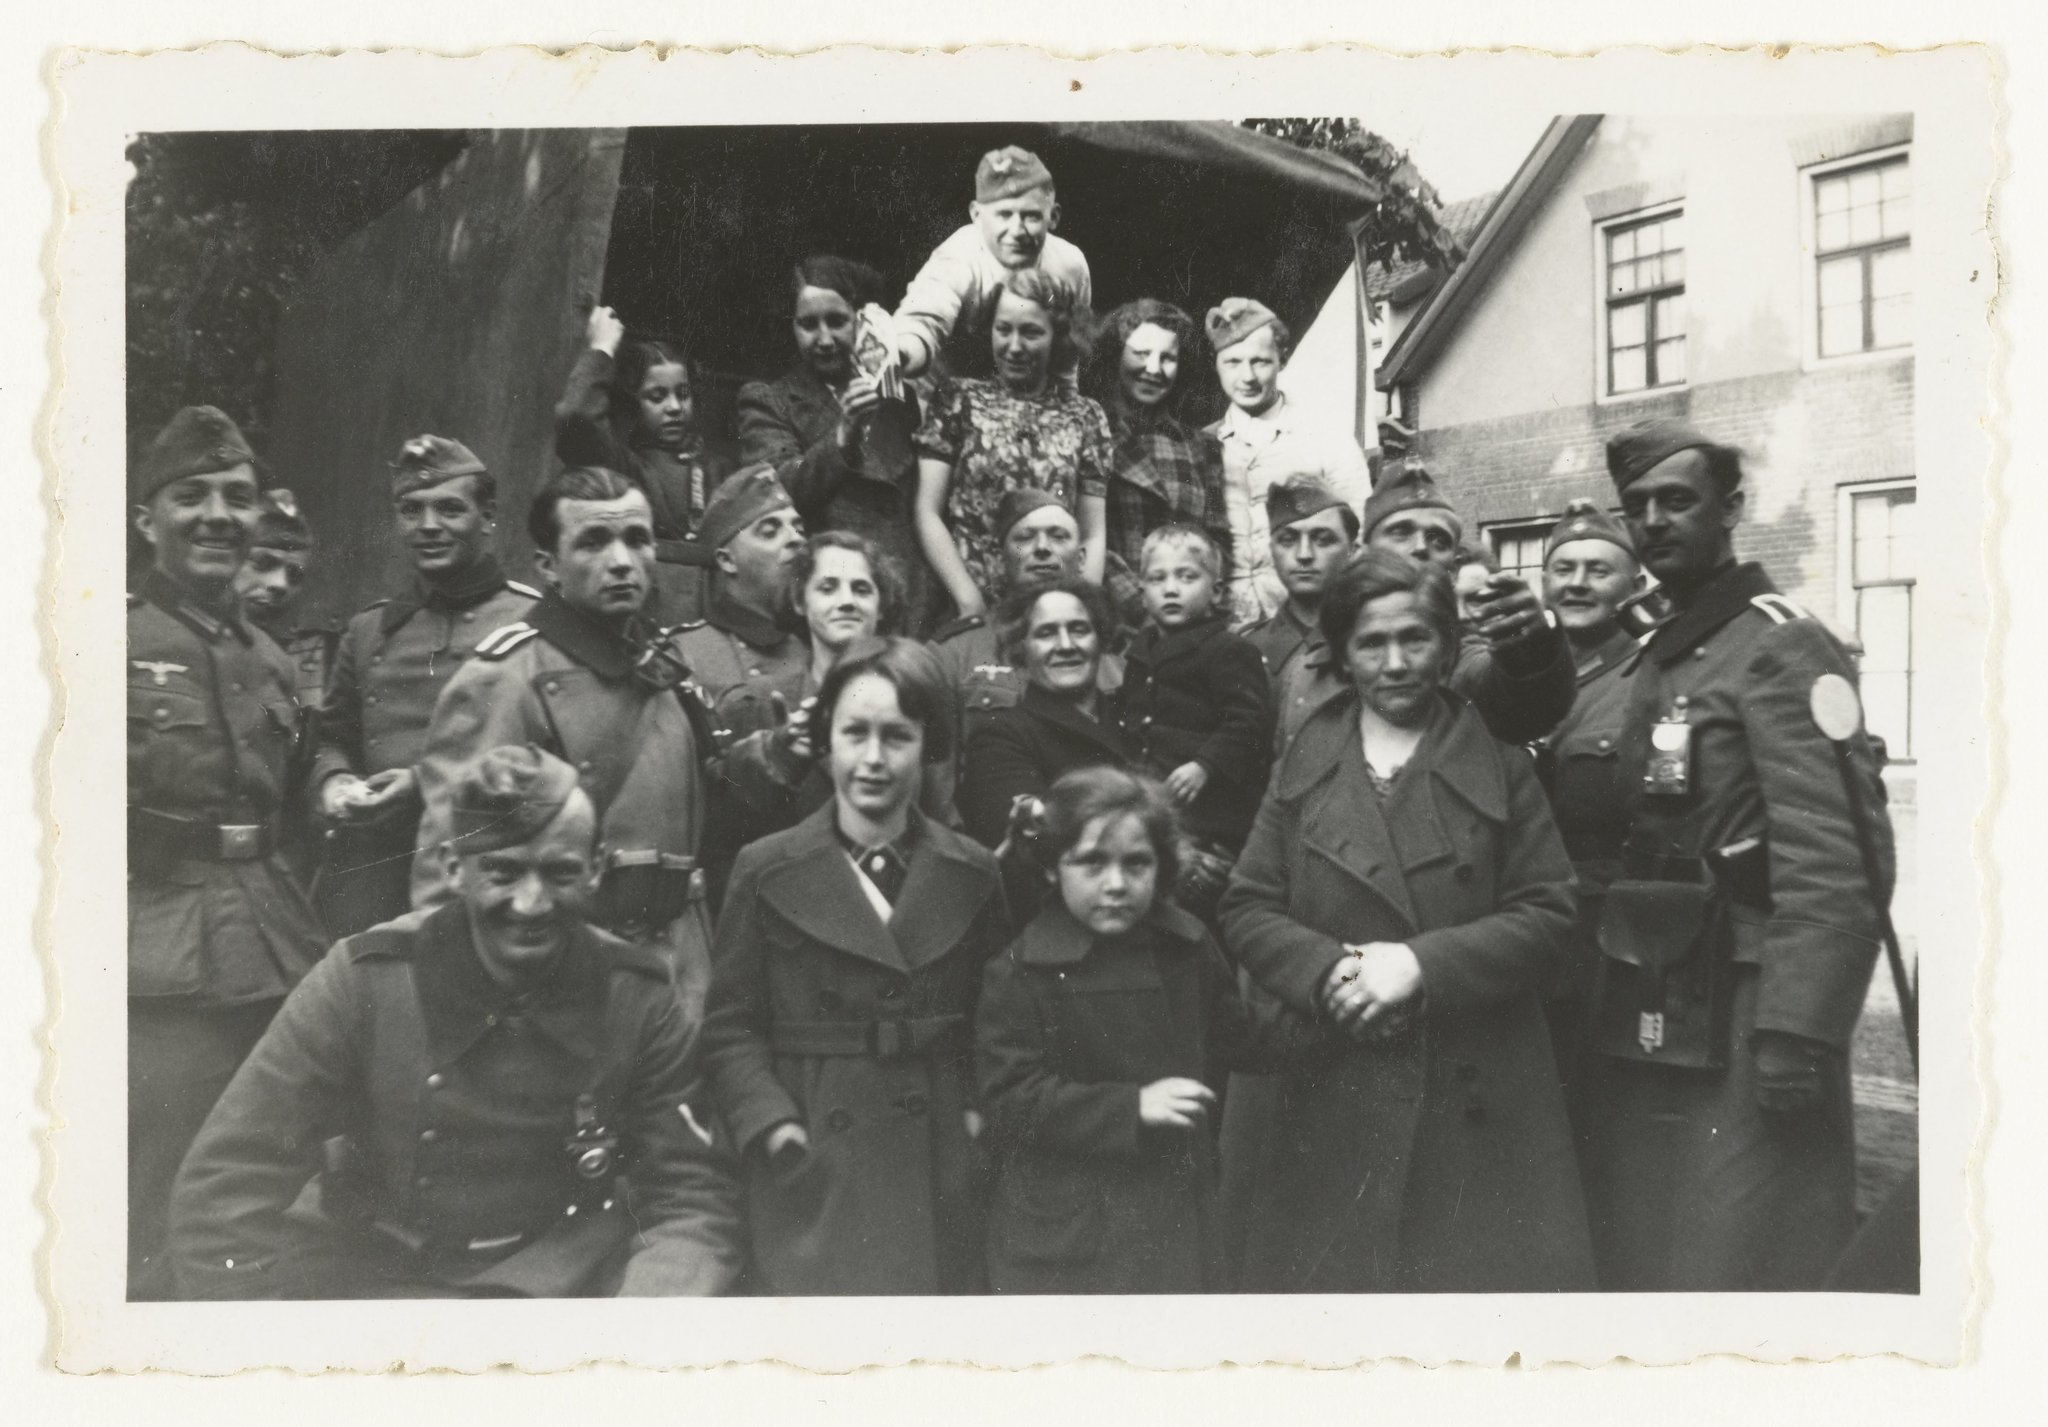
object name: photograph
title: Wehrmachtsoldaten met Nederlanders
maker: Anonymous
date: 1941-1942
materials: photographic support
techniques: gelatin silver print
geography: netherlands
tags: occupier and civilians, occupation ~ war, netherlands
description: Een groep Wehrmacht militairen in en bij een legertruck. Tussen hen in staan Nederlanders. Een van de militairen in de truck laat een pakje zien.